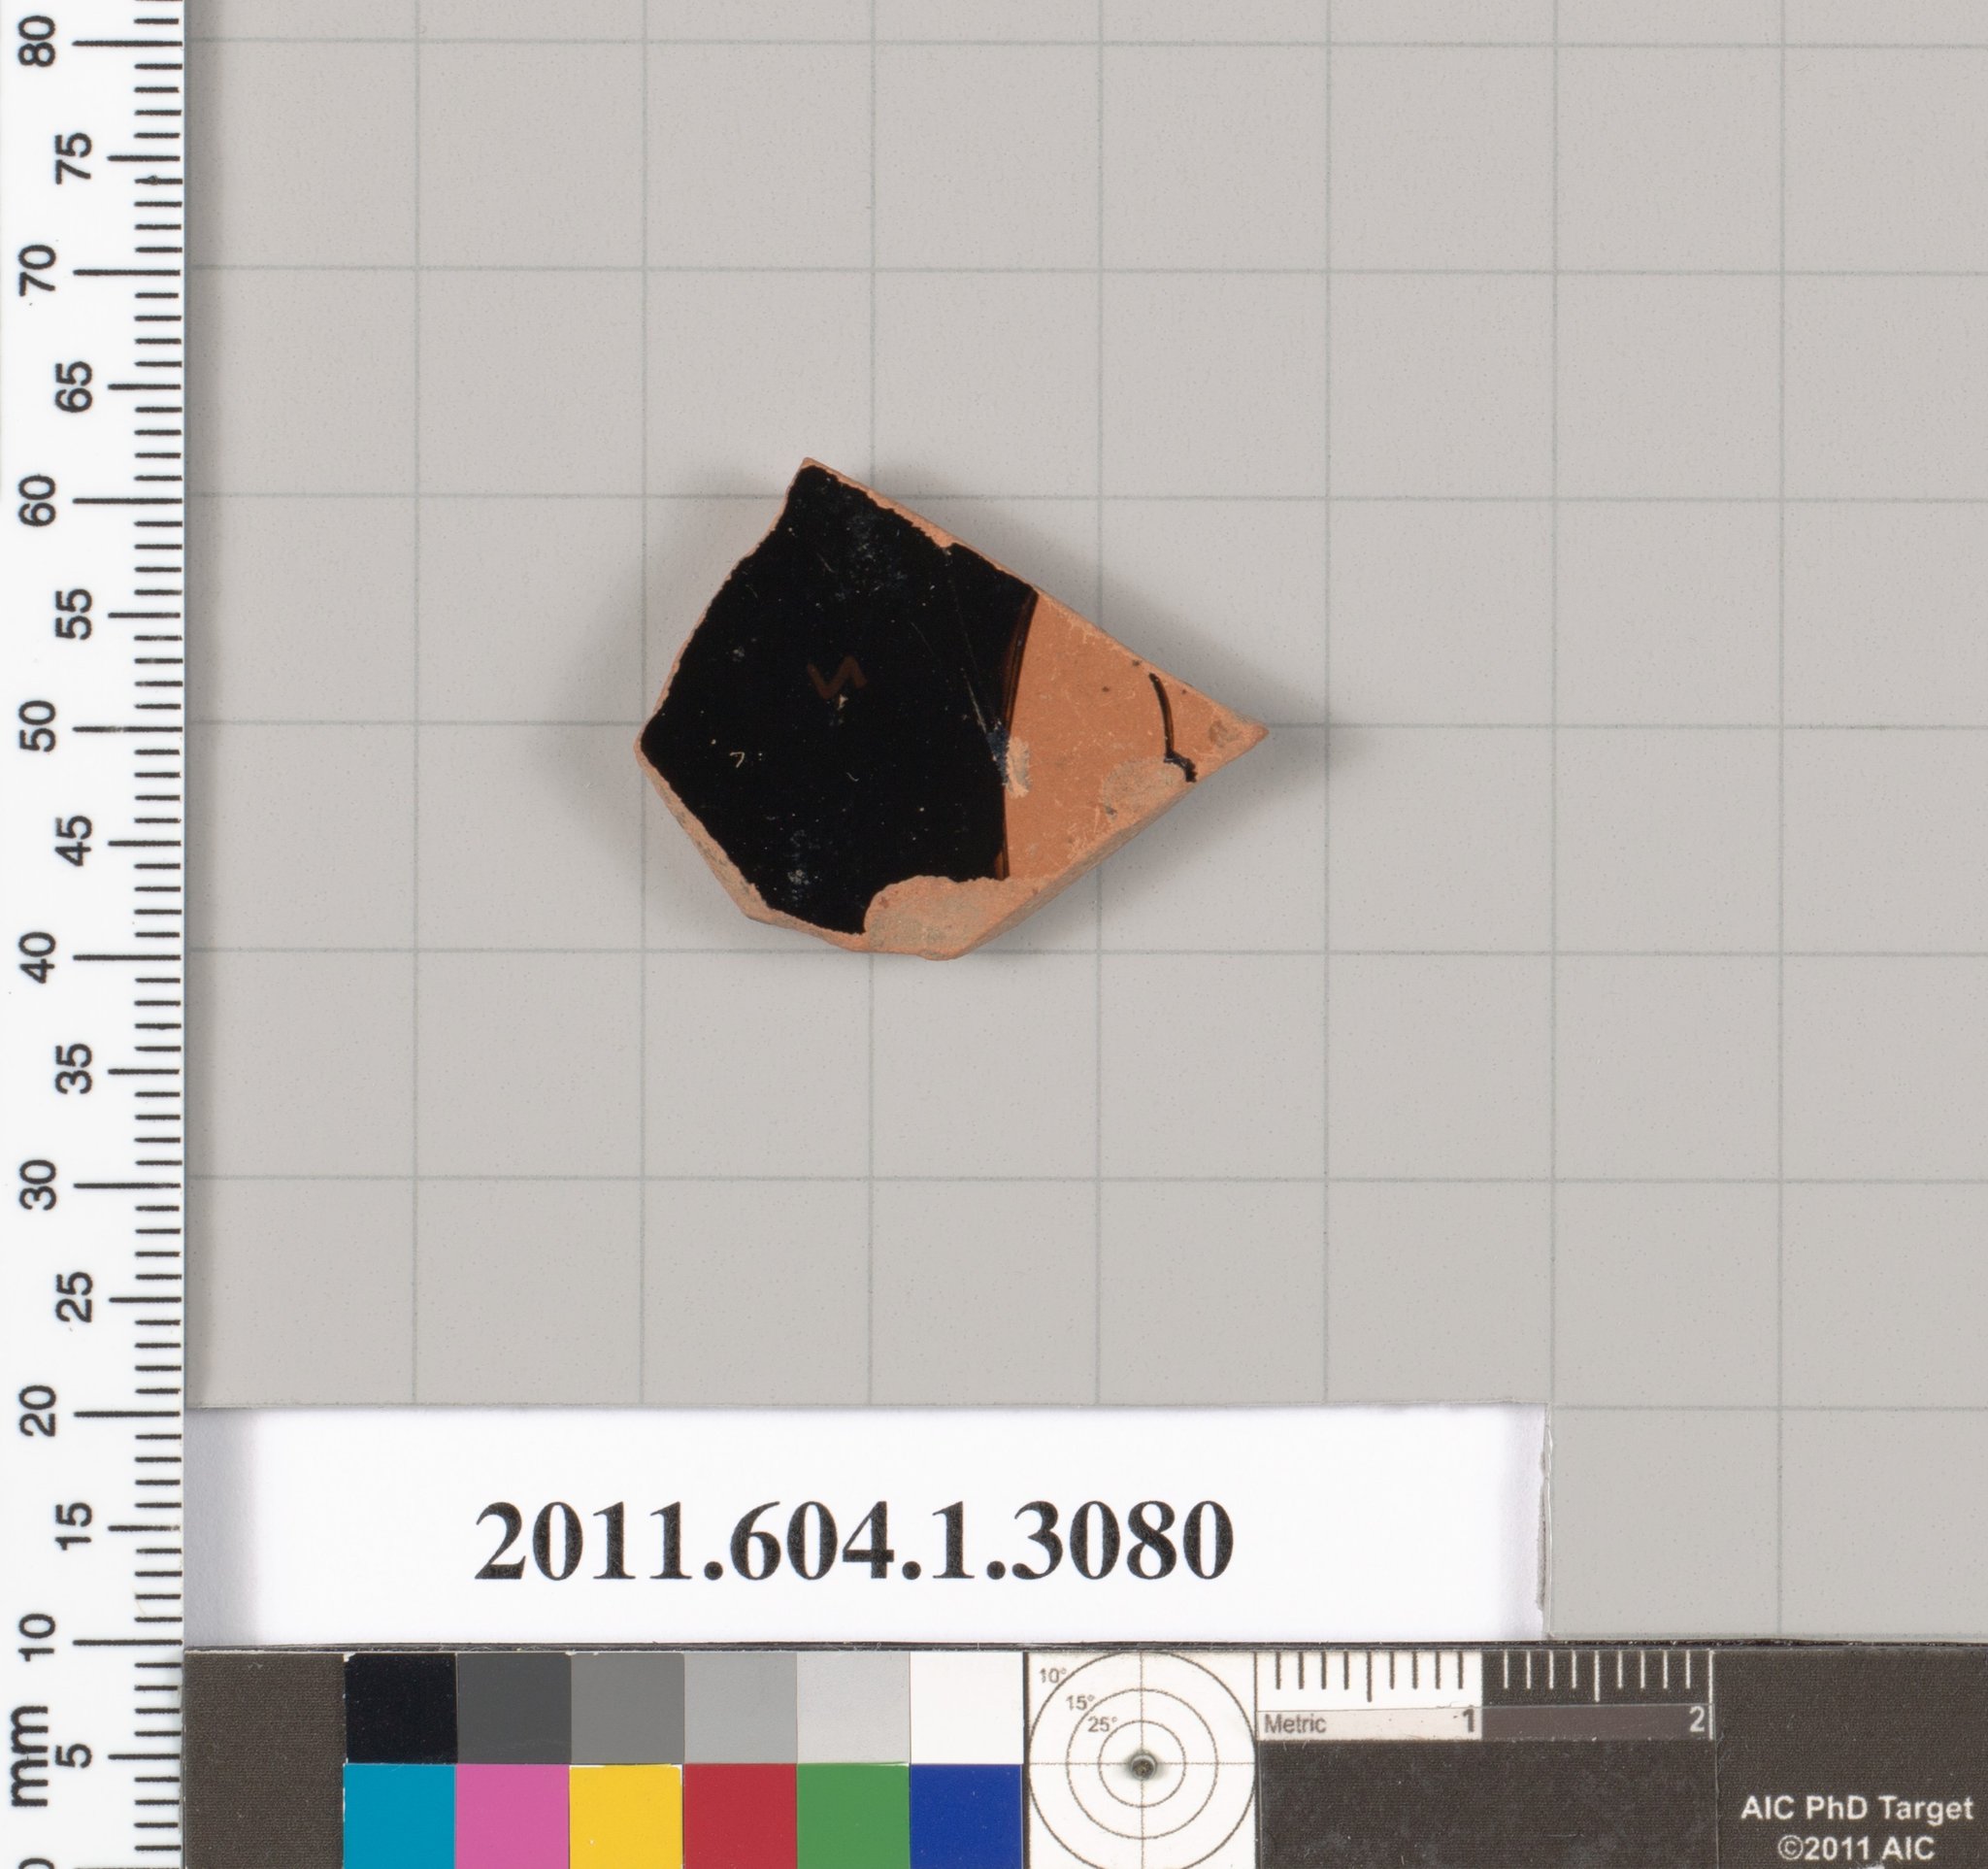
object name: kylix fragment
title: Terracotta fragment of a kylix (drinking cup)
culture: greek, attic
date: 490-480 BCE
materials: terracotta